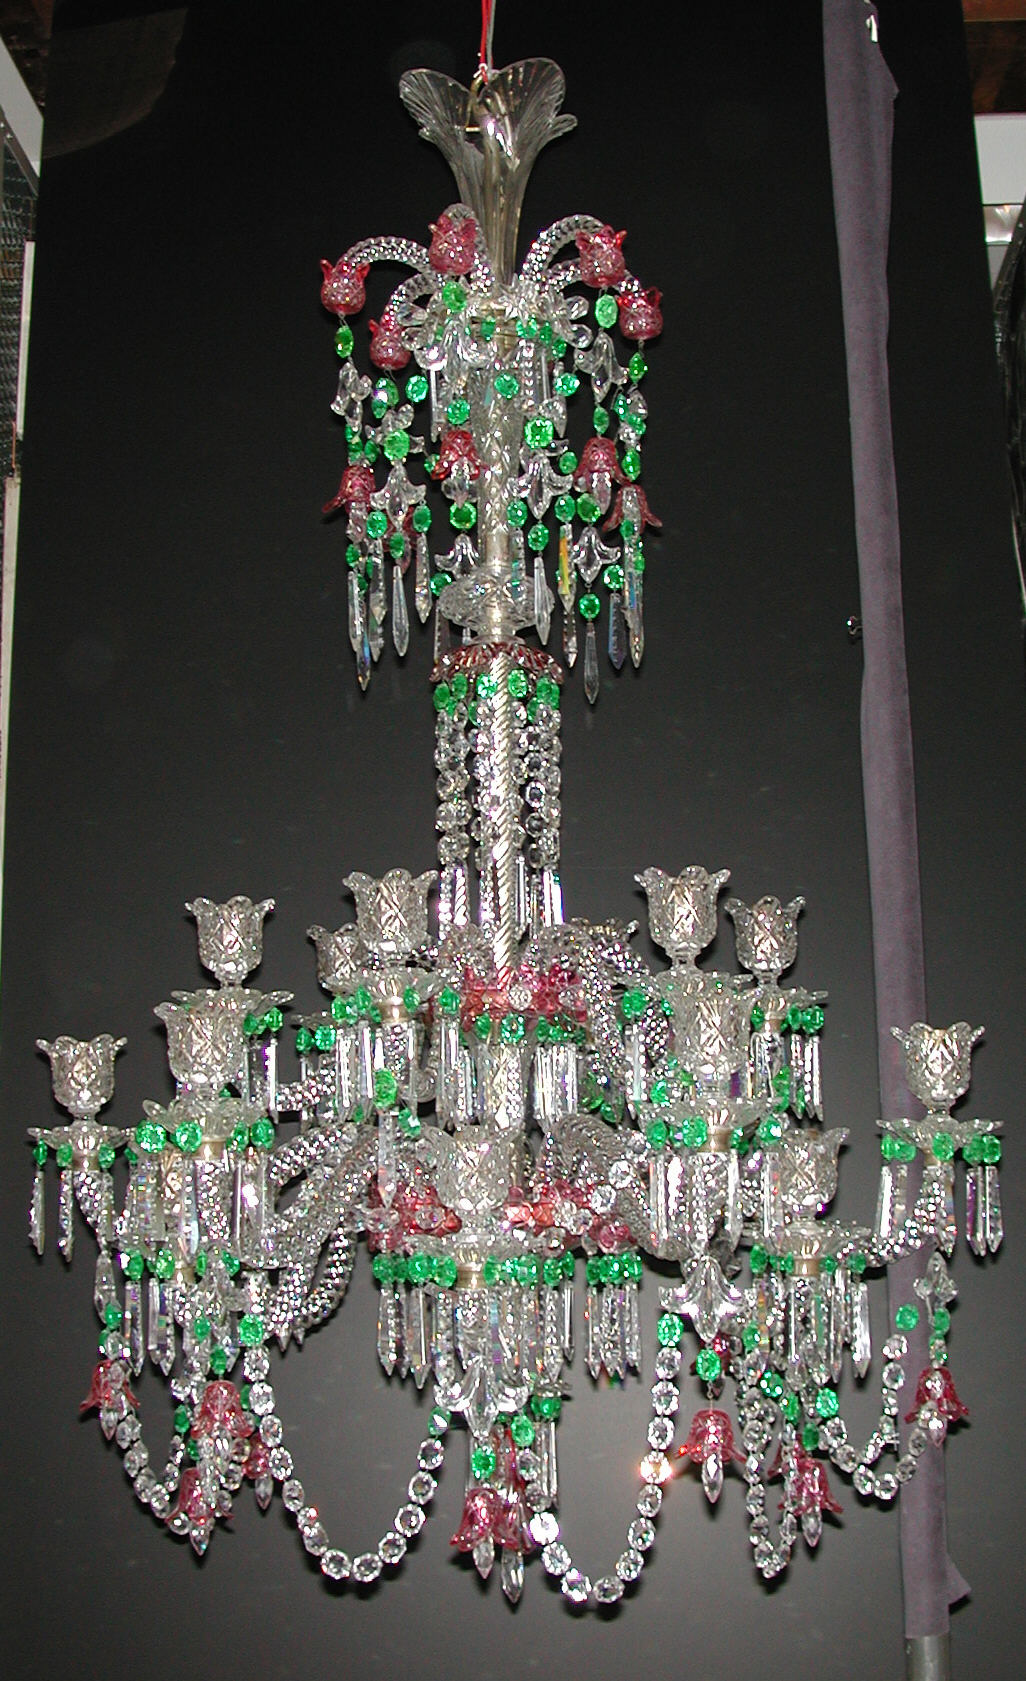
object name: chandelier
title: Eighteen-branch chandelier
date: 1825-1850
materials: glass